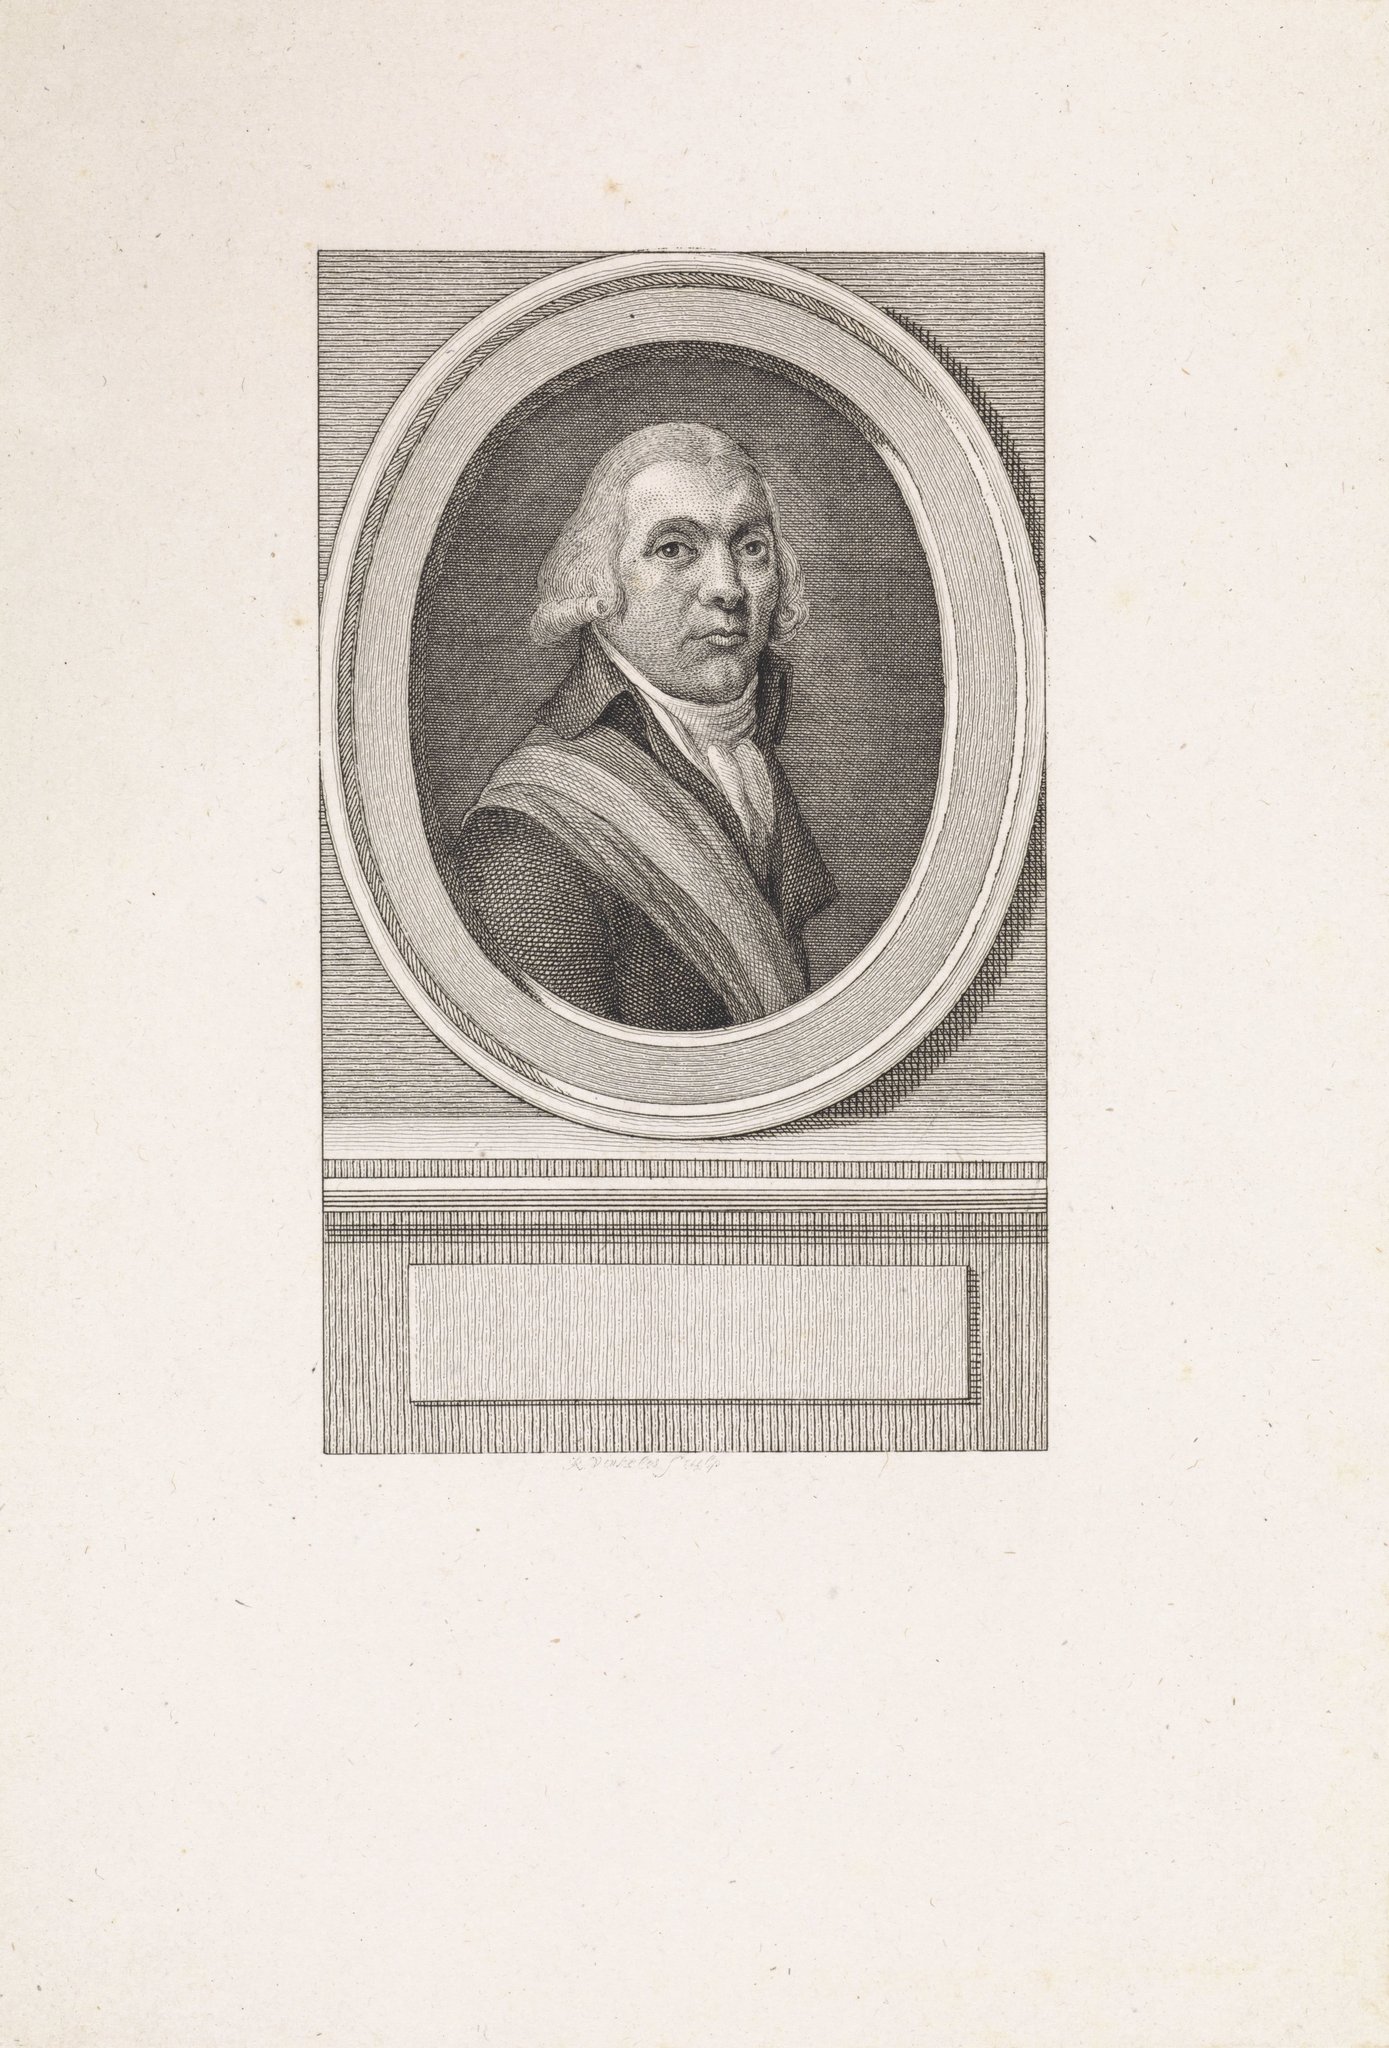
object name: print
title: Portret van Joachim Nuhout van der Veen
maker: reinier vinkeles (i)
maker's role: draughtsman, print maker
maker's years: 1741-1816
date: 1786-1809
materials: paper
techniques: engraving, etching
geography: amsterdam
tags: amsterdam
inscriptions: collector's mark: Lugt 2228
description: Latere staat prent ook gebruikt als boekillustratie in: Wagenaar, Jan. Vaderlandsche historie, (...) ten vervolge van Wagenaars Vaderlandsche historie. Dl. 1-43. Amsterdam: Johannes Allart, 1786-1809.